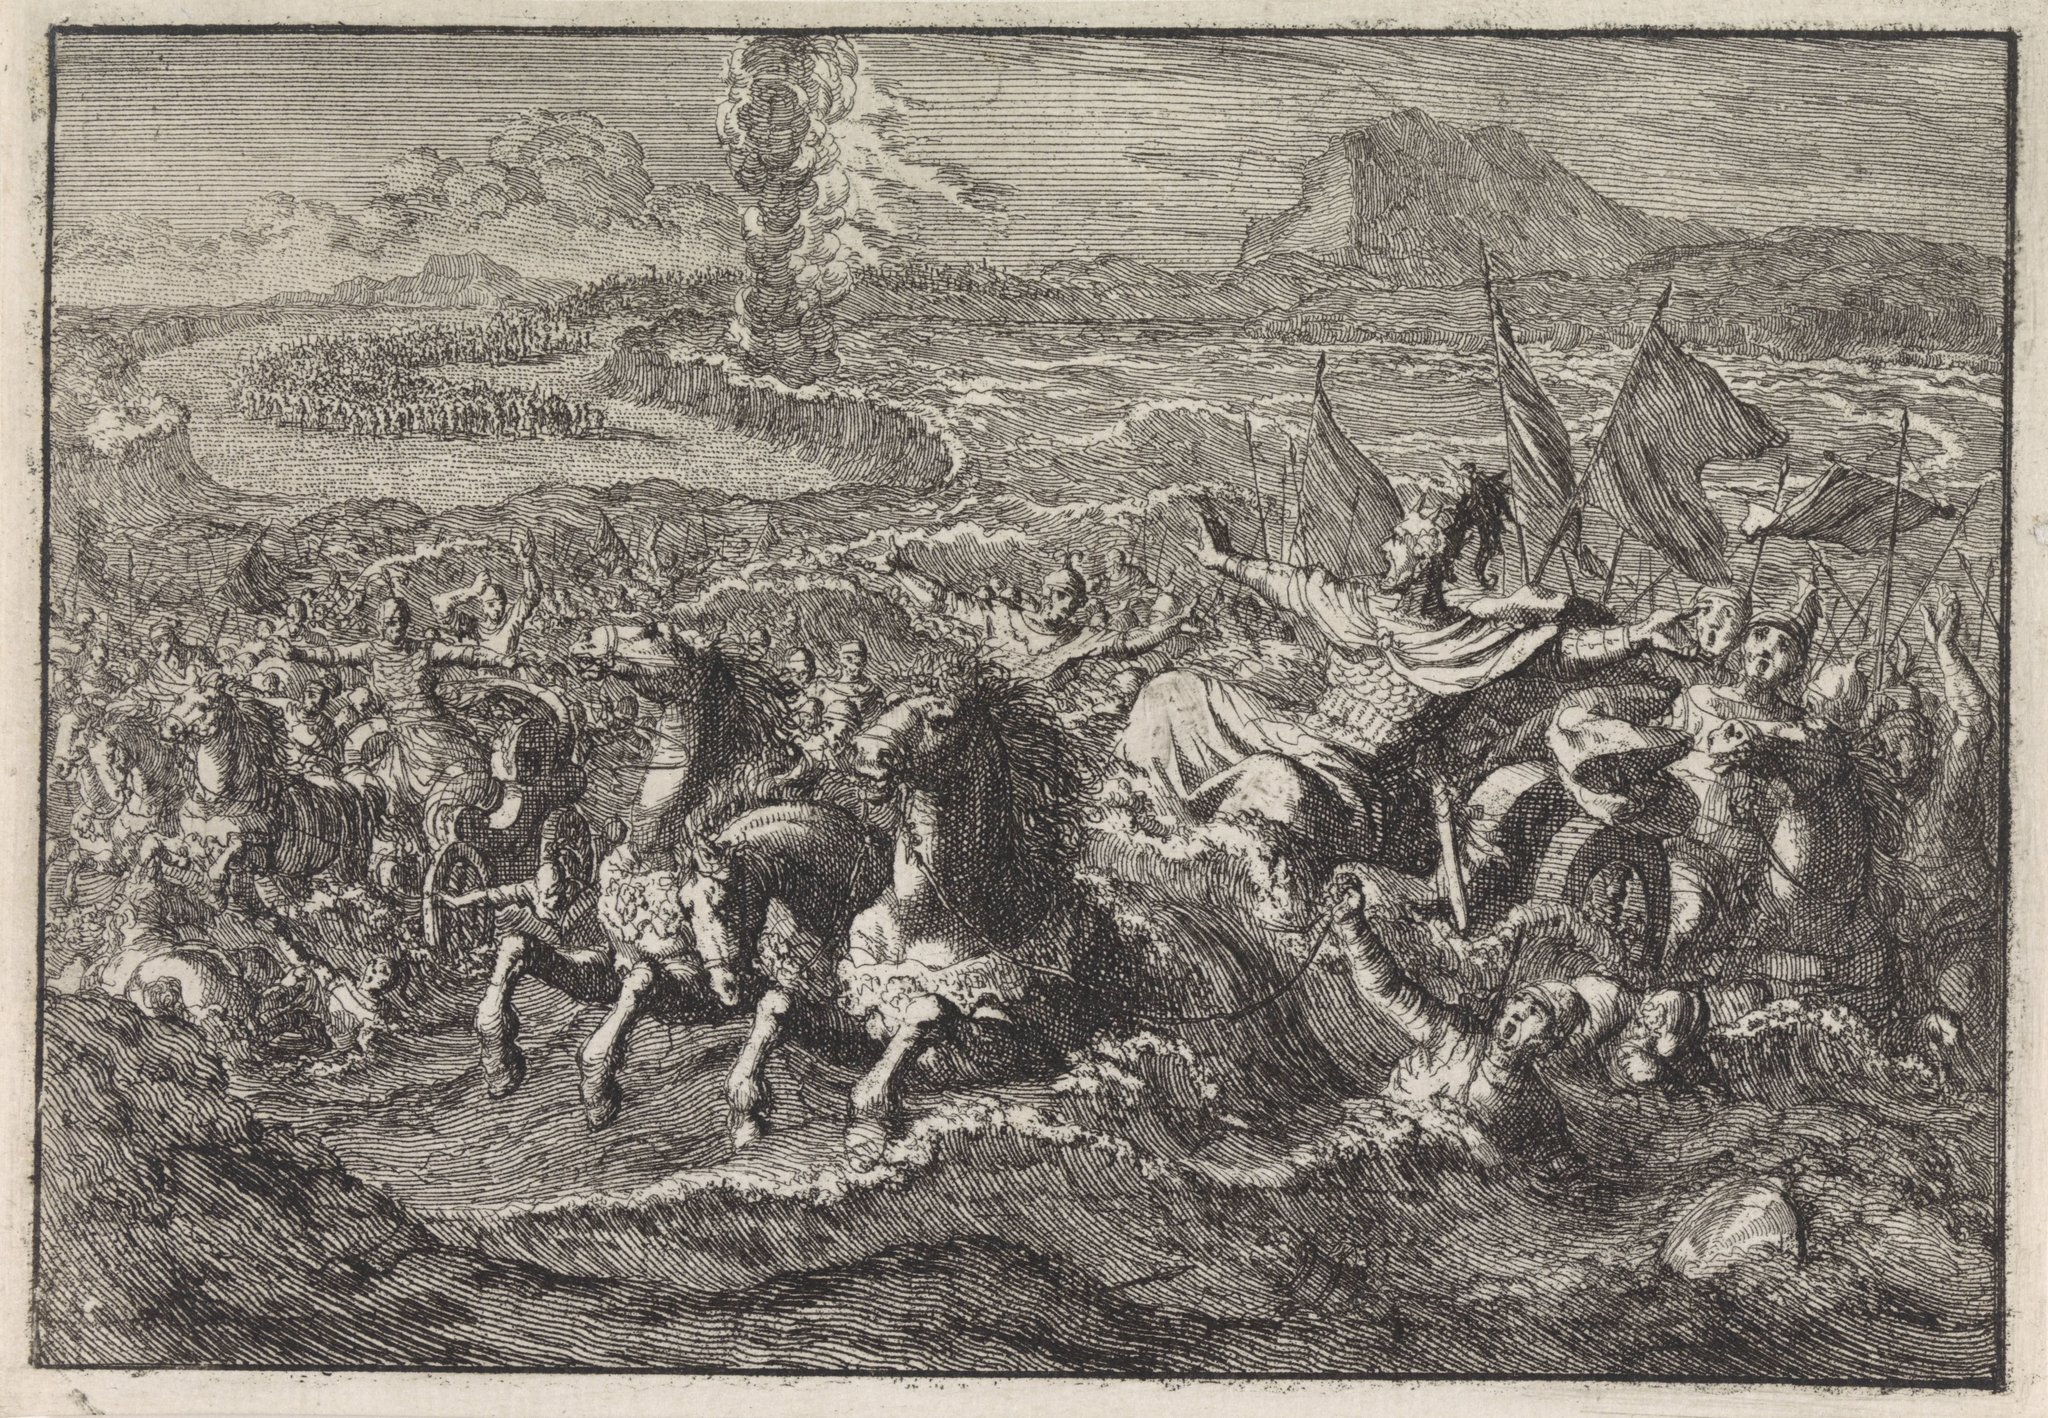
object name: print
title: Vernietiging van het Egyptische leger in de Rode Zee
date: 1703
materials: paper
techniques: etching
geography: haarlem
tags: with his people safe on the shore, moses raises his hands and causes the water to return; pharaoh's army perishes in the water (red sea)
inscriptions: collector's mark: Lugt 2228, number: ‘28’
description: De boekillustraties voor de Mortierbijbel hebben verschillende staten en kopieën, waarbij de chronologische volgorde moeilijk te achterhalen valt. Als boekillustraties werden ze bovendien herhaaldelijk opnieuw gebruikt voor andere boekwerken. Proefdruk van een boekillustratie voor David Martin. Historie des Ouden en Nieuwen Testaments. Amsterdam, Pieter Mortier, 1703. Deel I.